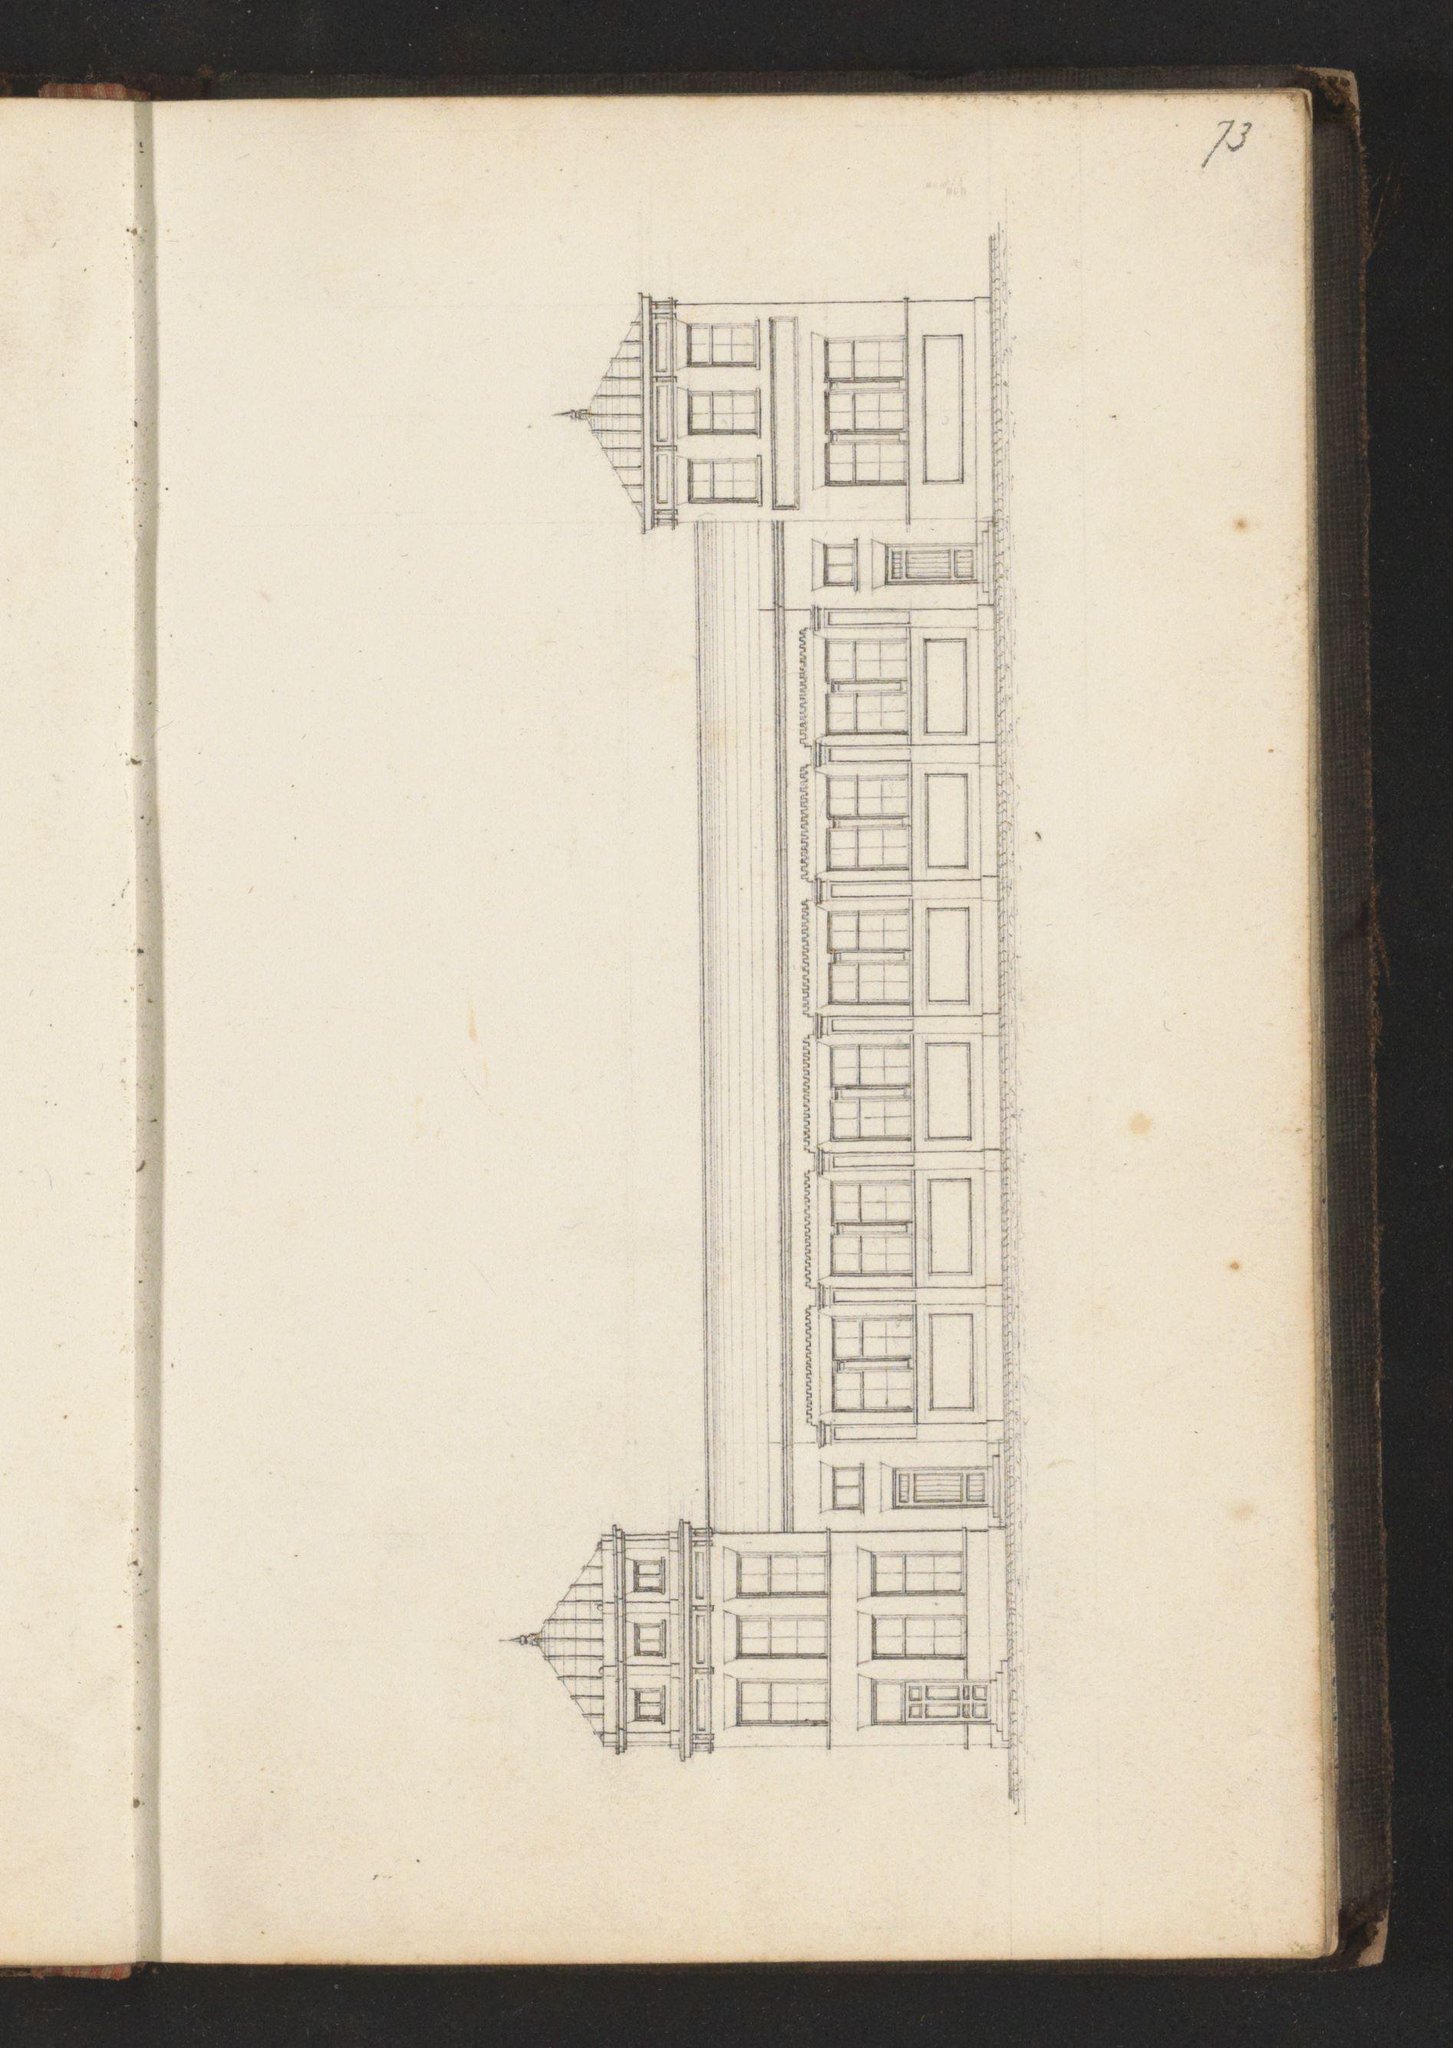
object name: sketchbook leaf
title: Opstand van de façade van een gebouw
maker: willem springer jr.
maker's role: draughtsman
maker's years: 1815-1907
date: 1864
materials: ink, paper, pencil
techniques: pen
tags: façade (of house or building)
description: Pagina 73 uit een schetsboek met 164 pagina's.